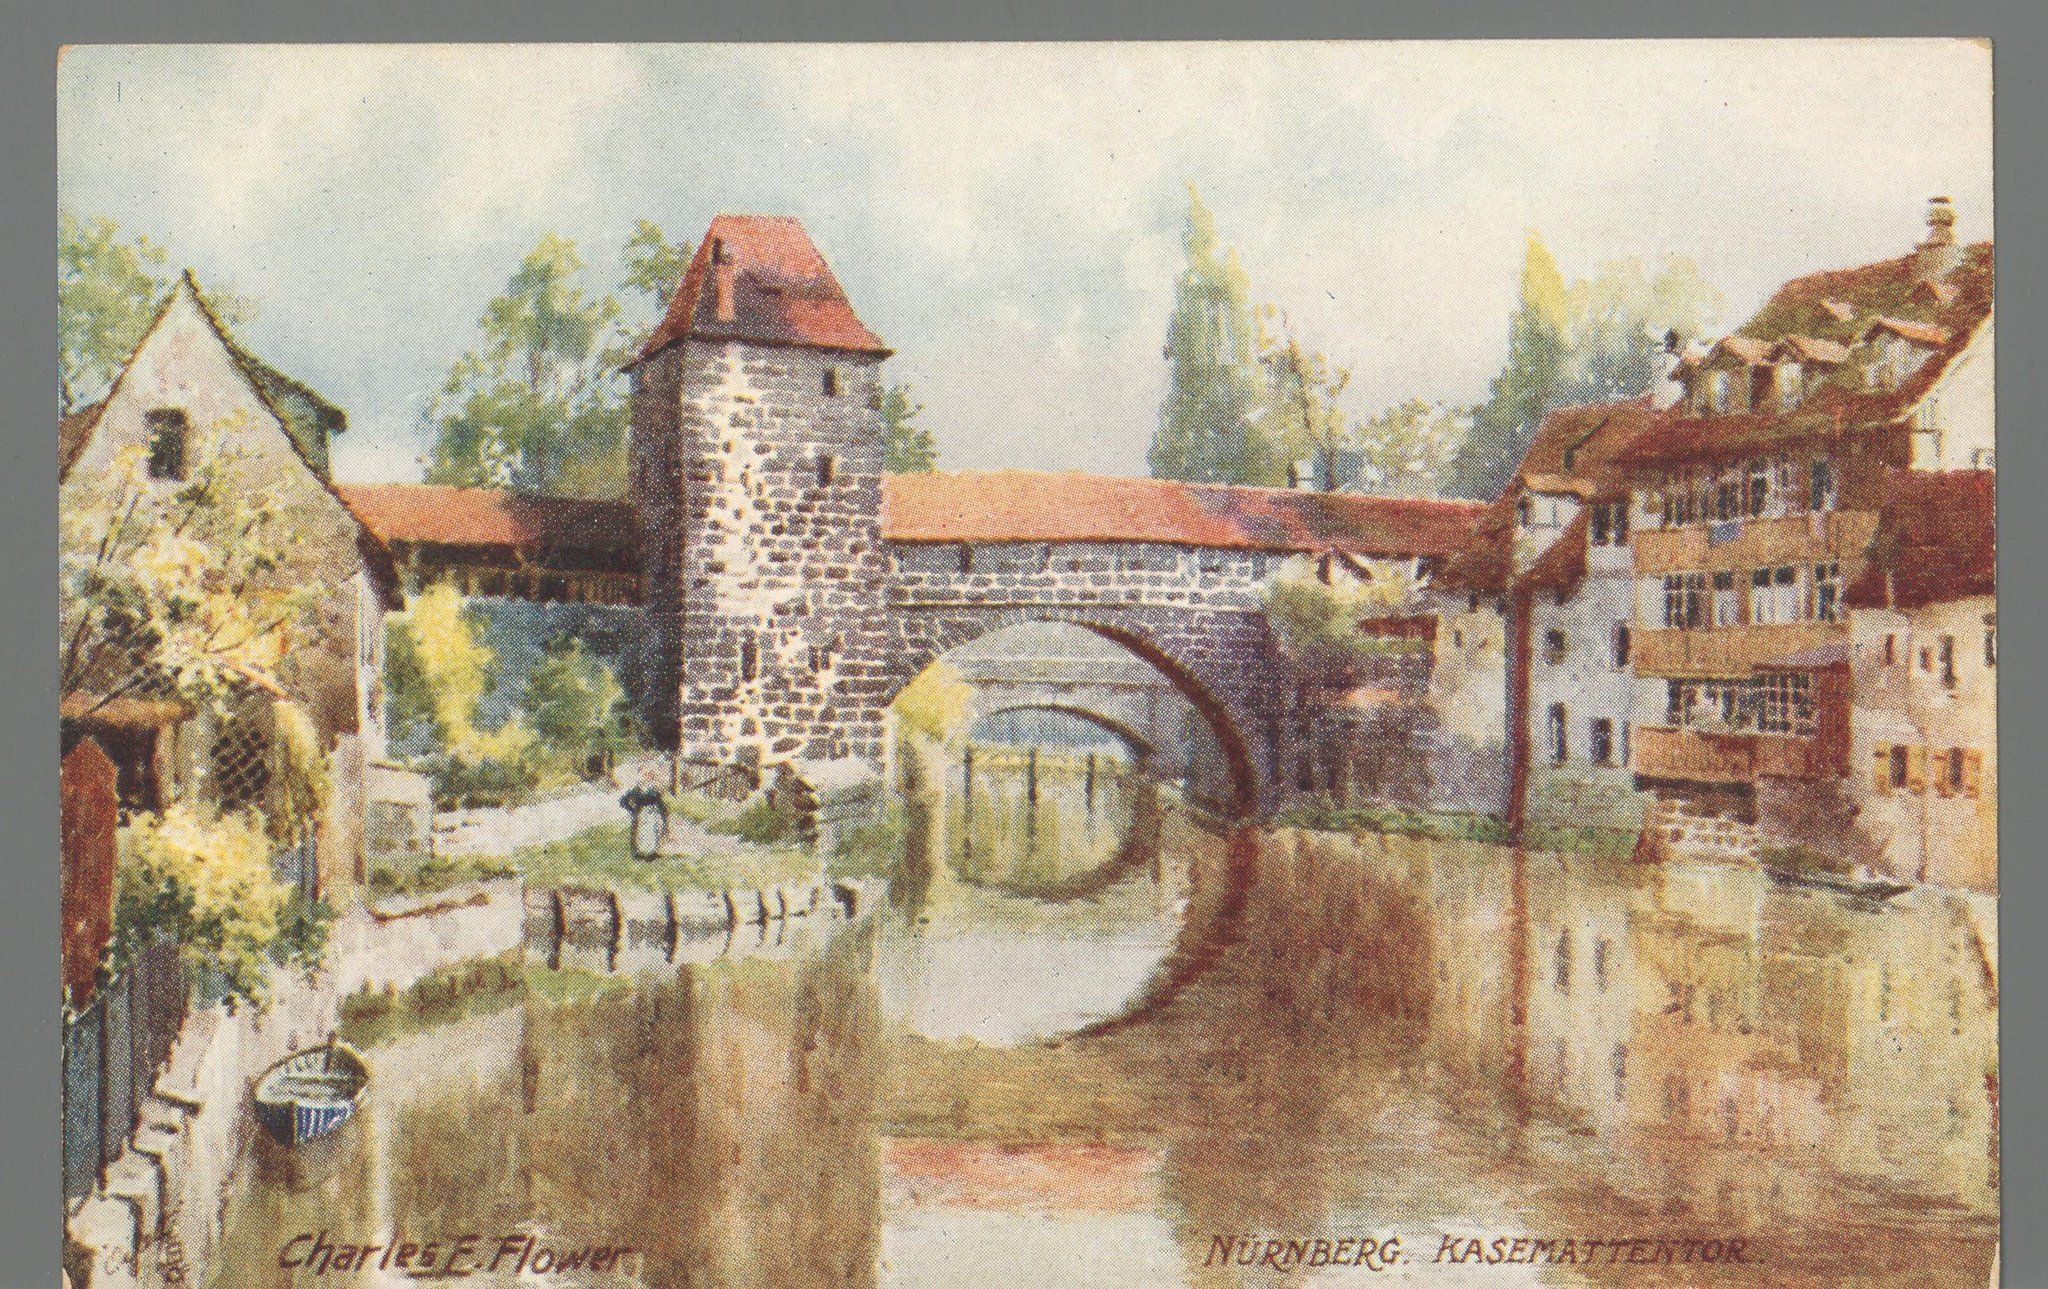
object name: photomechanical print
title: Oilette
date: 1905-1909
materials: cardboard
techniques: writing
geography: london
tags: canals, waters (in city), bridge in city across river, canal, etc., city-gate